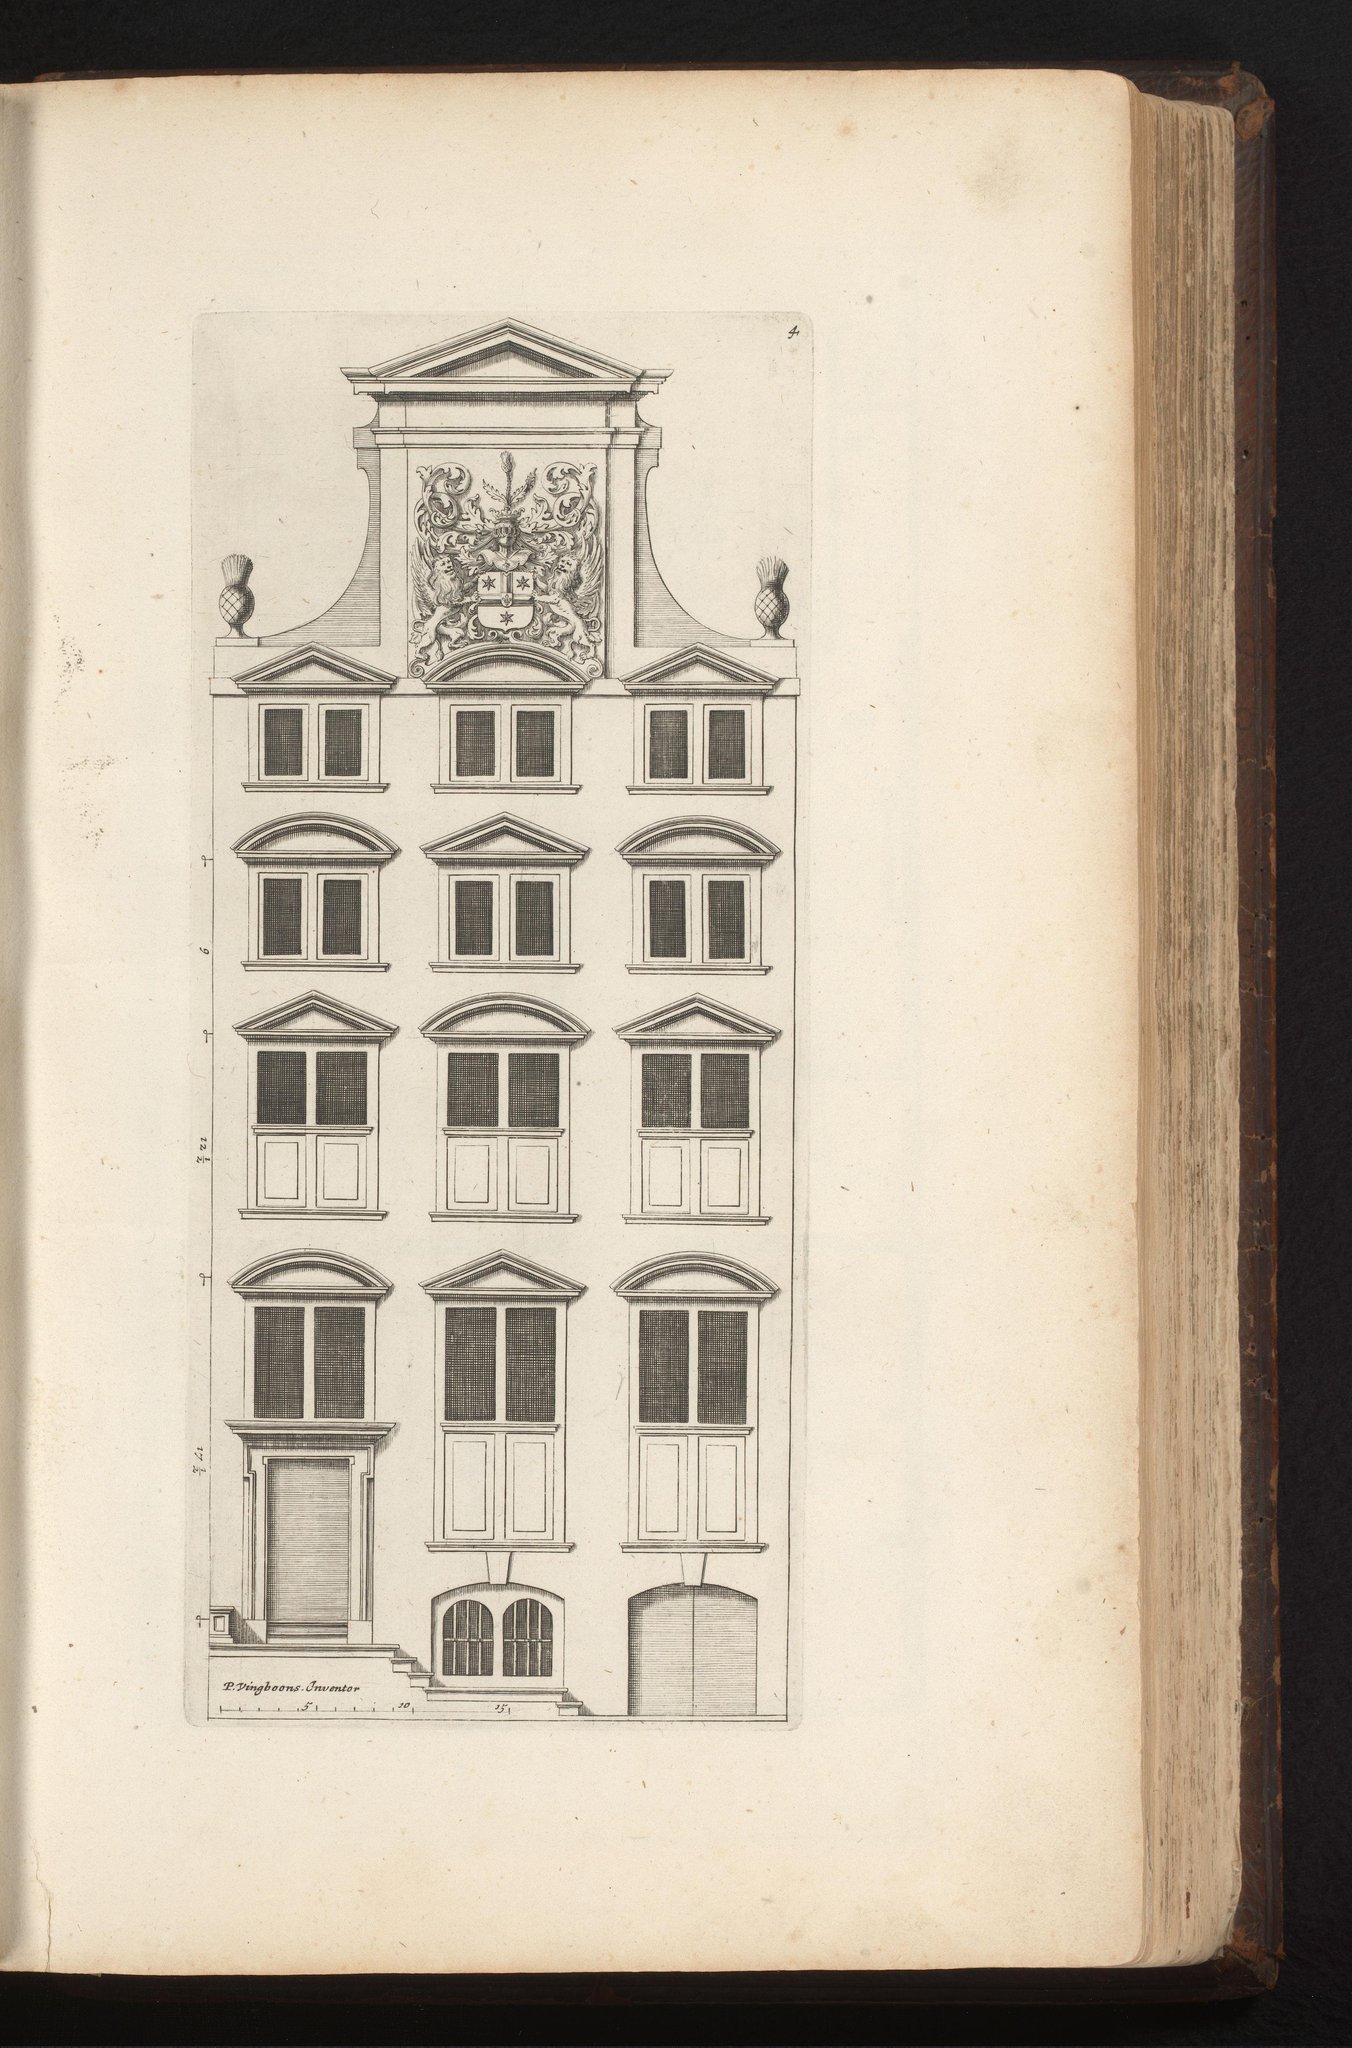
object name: book illustration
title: Gevel van een herenhuis aan de Herengracht te Amsterdam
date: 1648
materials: paper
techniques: engraving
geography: amsterdam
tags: urban housing, armorial bearing, heraldry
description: Prent uit: Afbeelsels der voornaemste gebouwen uyt alle die Philips Vingboons geordineert heeft. Amsterdam: Philips en Johannes Vinckboons en Johannes Willemszoon Blaeu, 1648.